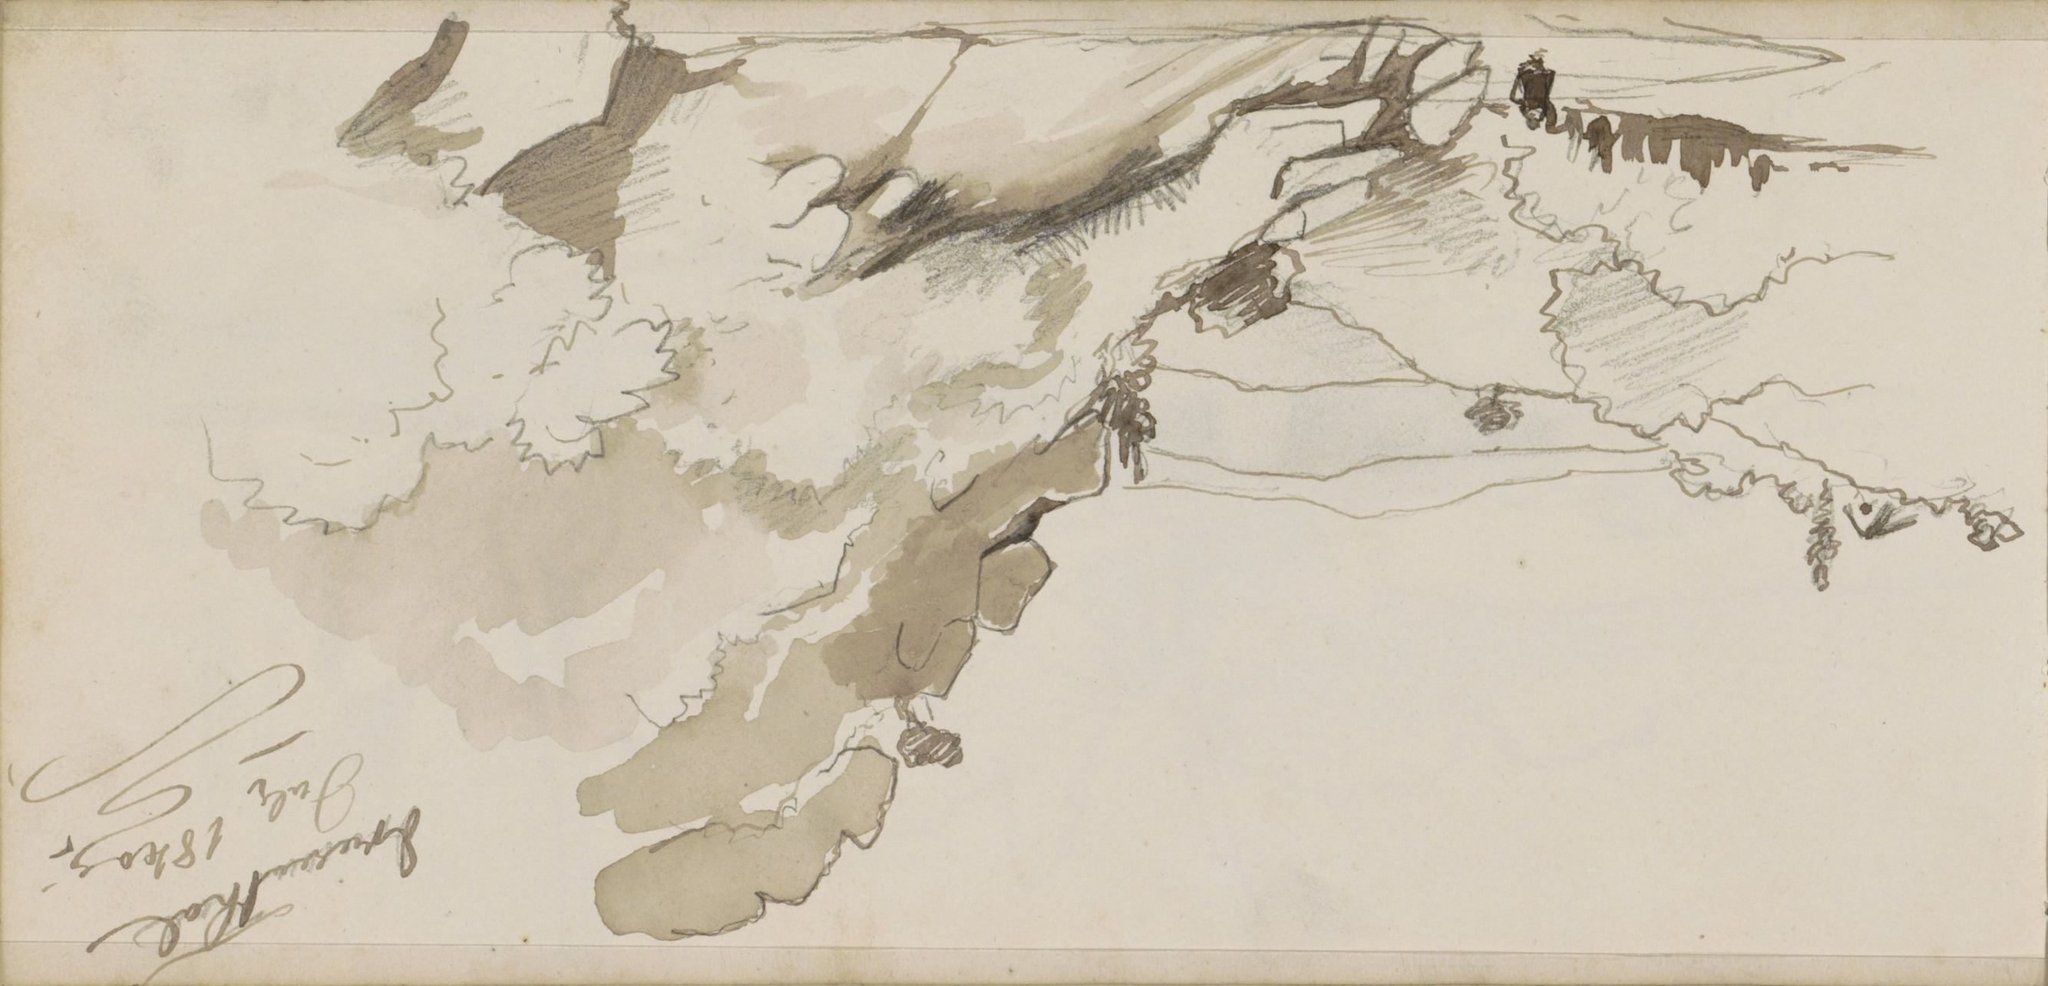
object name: sketchbook leaf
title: Landschap met een figuur in een dal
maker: johannes tavenraat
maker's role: draughtsman, painter, print maker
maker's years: 1809-1881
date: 1807-1840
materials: ink, paper, pencil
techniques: brush, pen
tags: dale, valley, landscapes (+ landscape with figures, staffage)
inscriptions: date and inscription: ‘[...]thal/ July 1840-’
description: Blad 53 verso uit een schetsboek met 63 bladen.